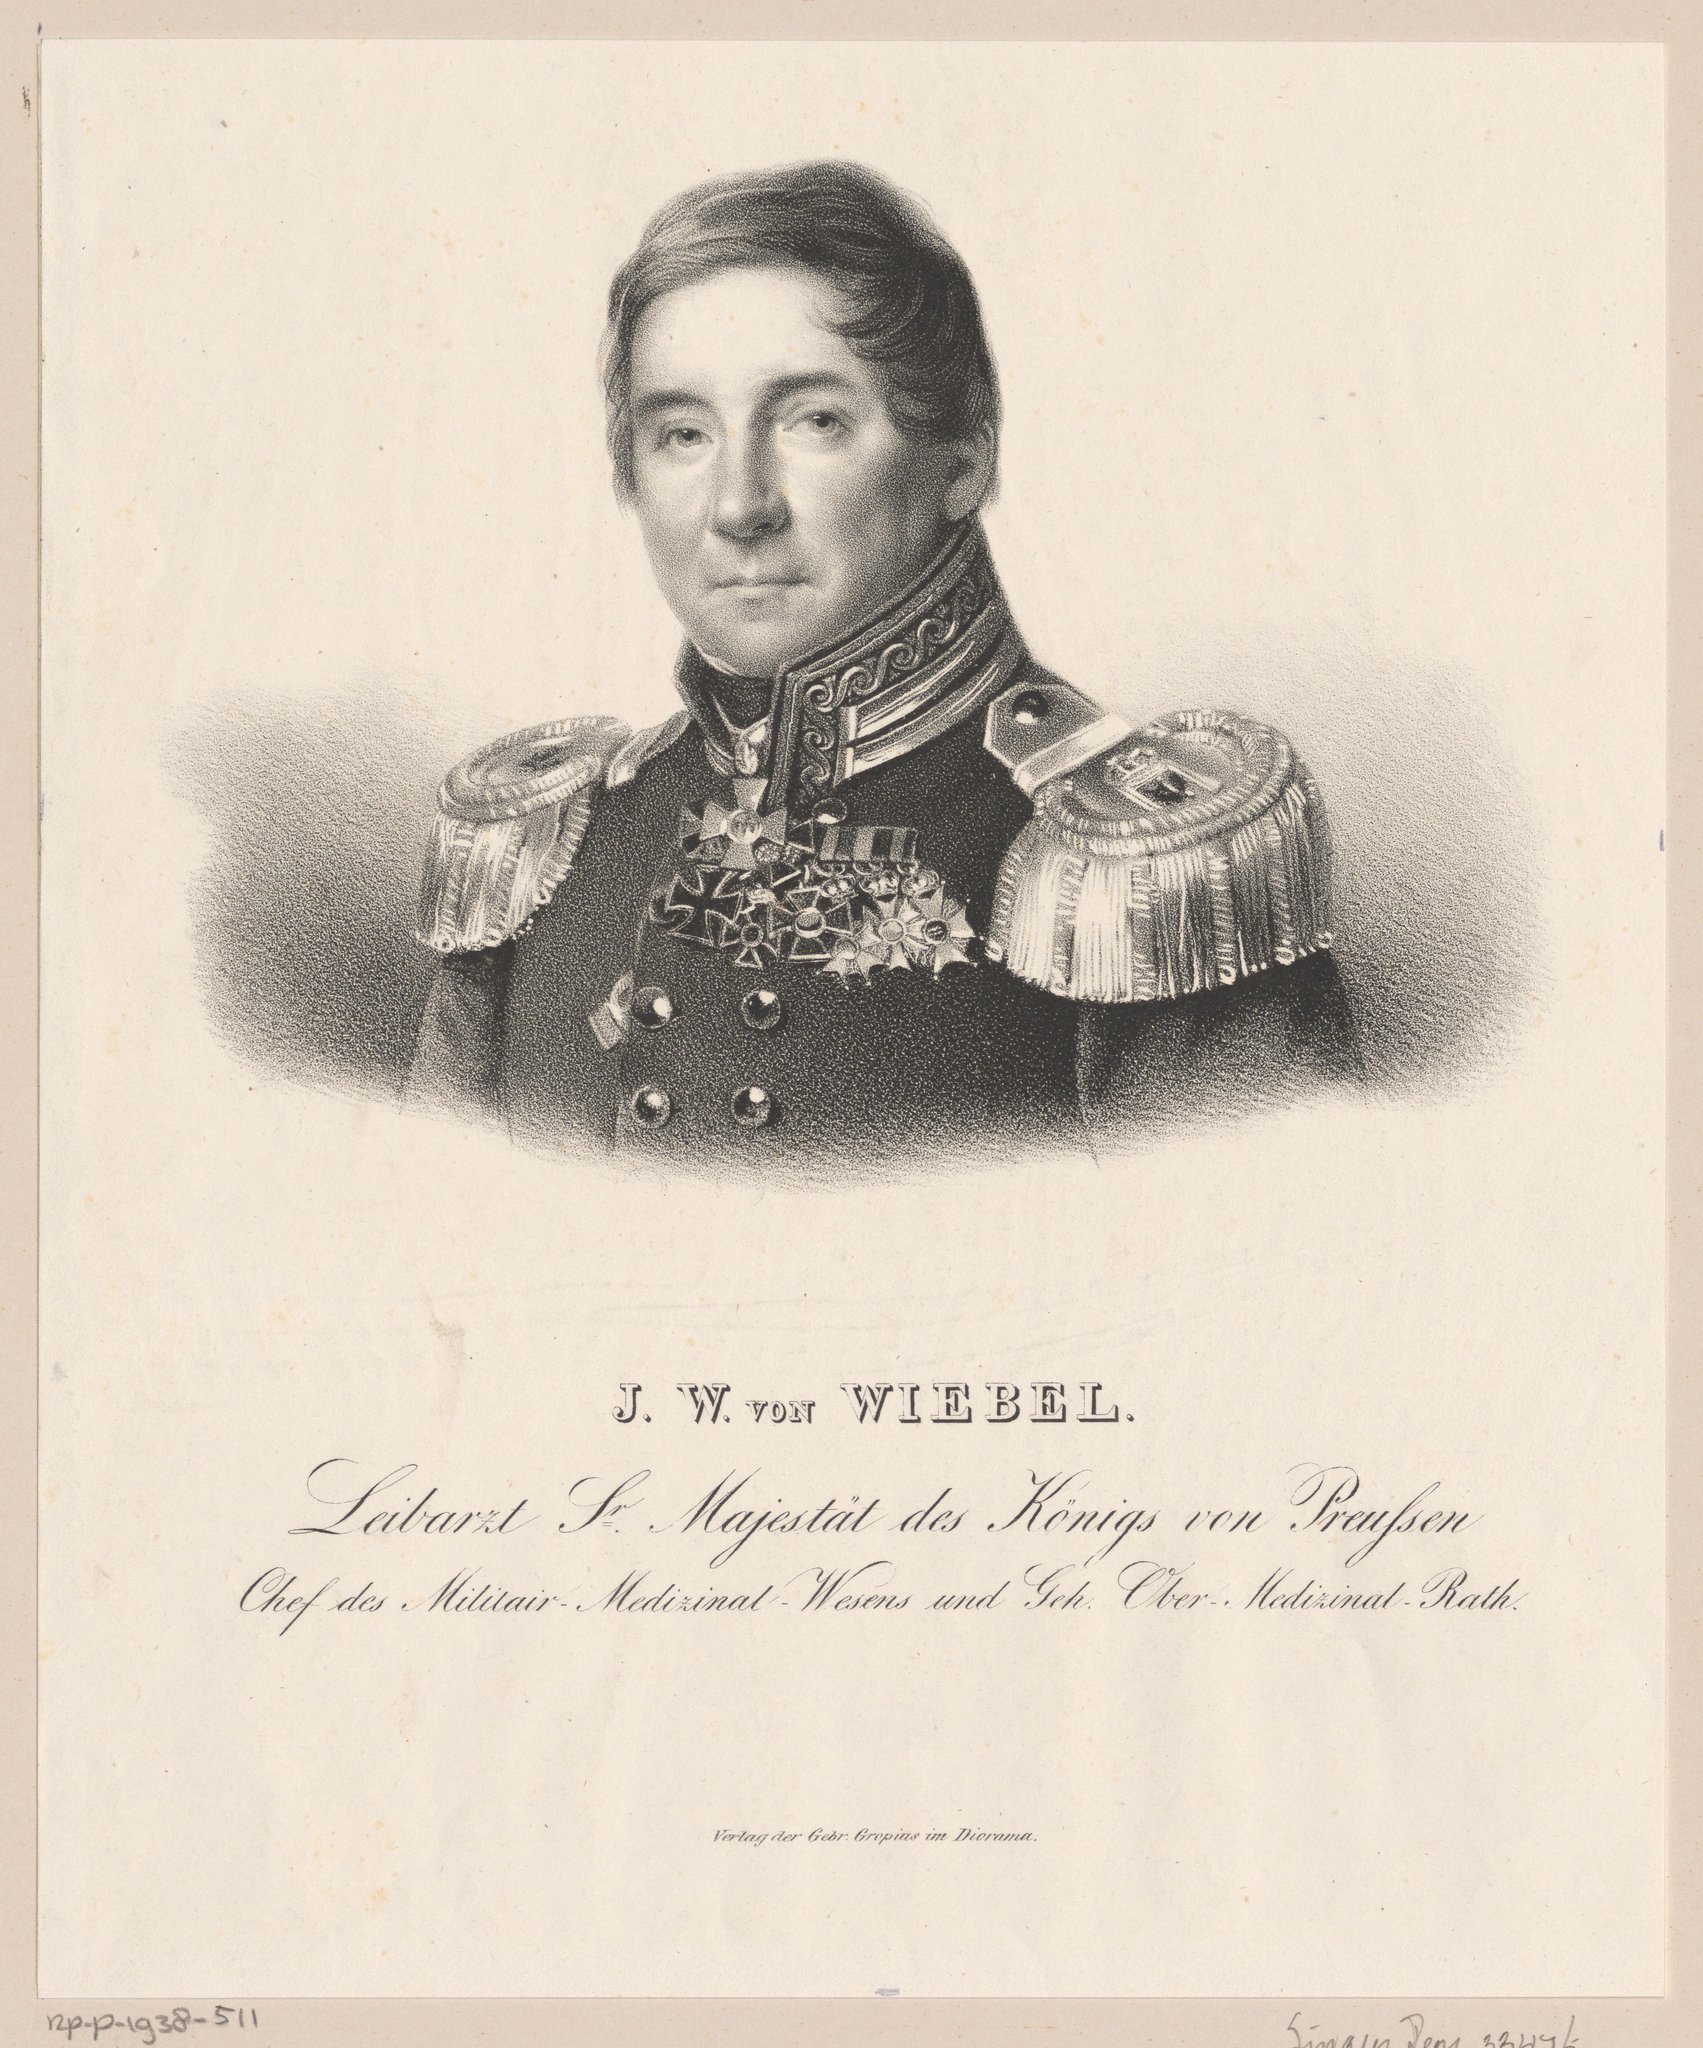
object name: print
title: Portret van Johann Wilhelm von Wiebel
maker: Anonymous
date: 1827-1840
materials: paper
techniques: lithograph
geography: berlin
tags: berlin, historical persons, physician, doctor, medals and other marks of military honour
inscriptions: collector's mark: Lugt 2228